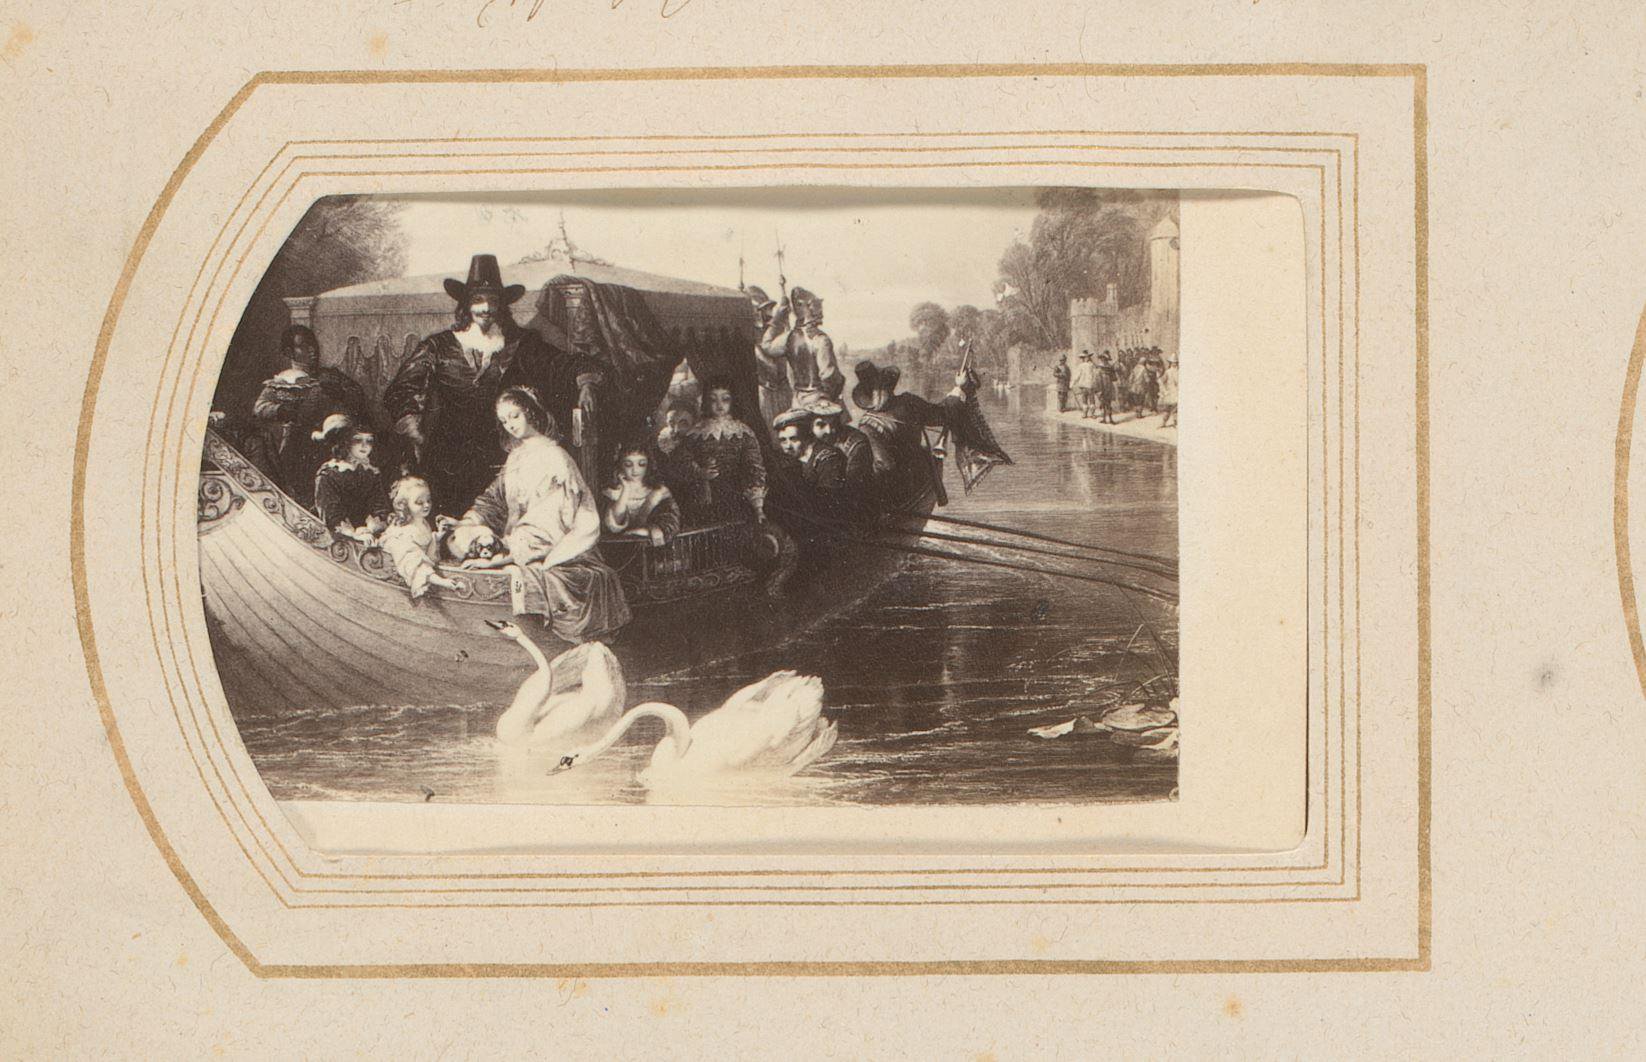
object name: photograph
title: Fotoreproductie van The happy days of Charles I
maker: Anonymous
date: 1870-1890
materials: cardboard, photographic support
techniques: albumen print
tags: adult woman, water-birds: swan, adult man, rowing-boat, canoe, etc., painting, drawing and the graphic arts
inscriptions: annotation: ‘Die glückligen Tagen Carl [...] I’, number: ‘275’